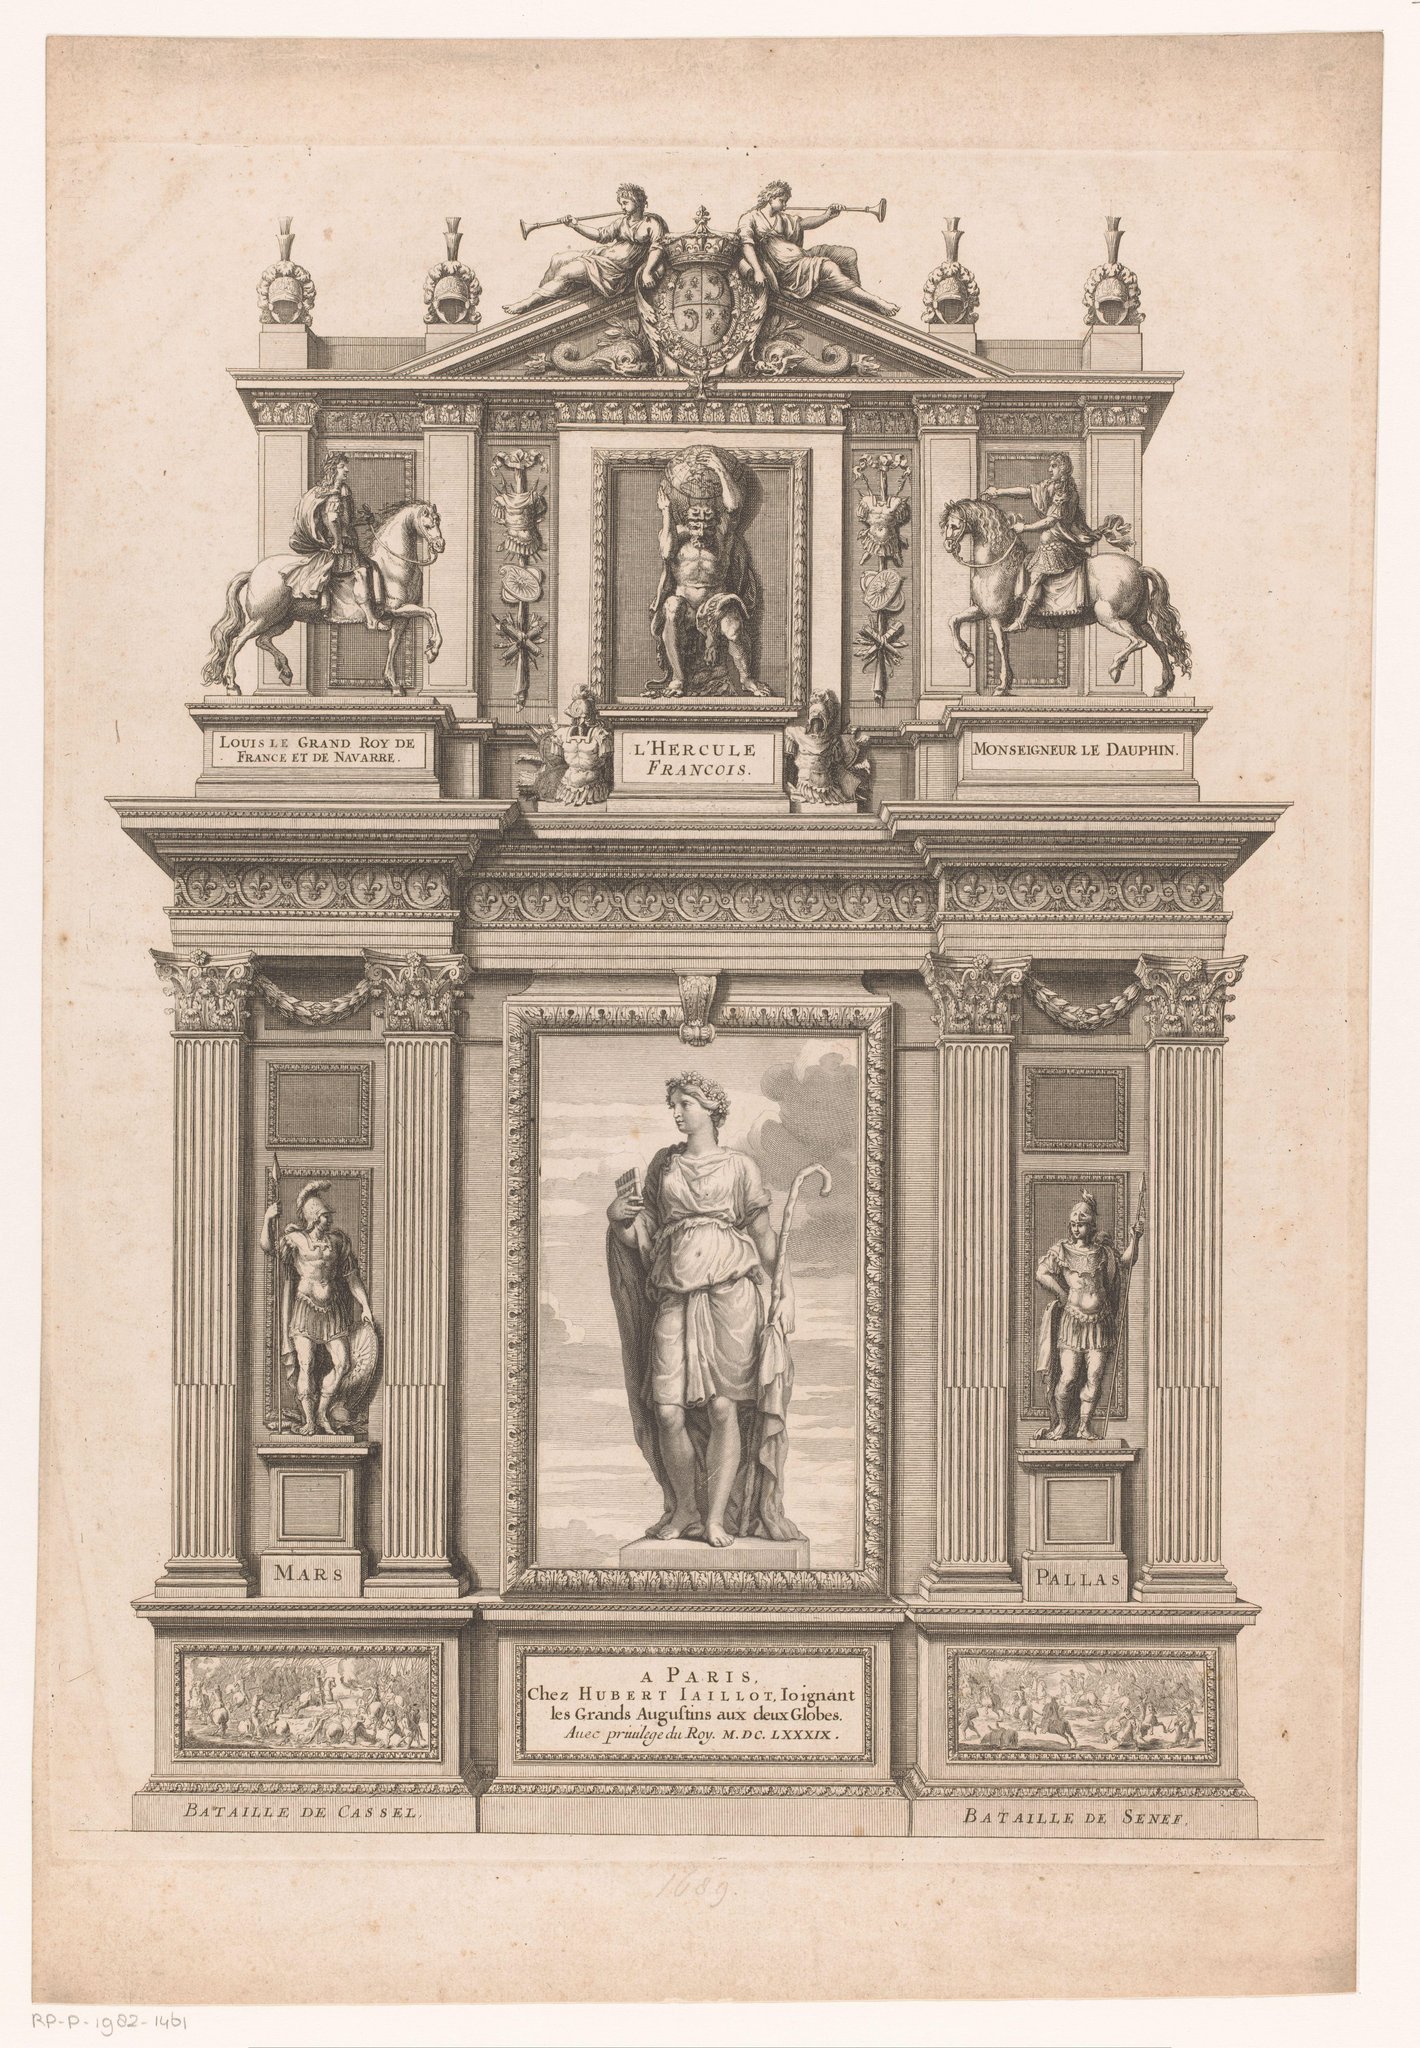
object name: print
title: Façade met herderin, goden en ruiterstandbeelden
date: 1689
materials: paper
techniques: engraving, etching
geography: amsterdam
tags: herding, herdsman, herdswoman, shepherd, shepherdess, cowherd, etc., equestrian statue, façade (of house or building), roman deities, and foreign deities included in the classical pantheon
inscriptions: collector's mark: Lugt 2760, collector's mark: Lugt 2228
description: Façade met in het midden een staande herderin met panfluit en staf. Links en rechts van haar staan de goden Mars en Pallas Athena op voetstukken tussen pilasters. Daarboven draagt Hercules de wereld op zijn schouders. Ruiterstandbeelden van Lodewijk XIV van Frankrijk en Lodewijk van Frankrijk flankeren hem. Aan de bovenzijde zitten twee op bazuinen blazende vrouwen aan weerszijden van een bekroond wapenschild. De prent is oorspronkelijk de titelpagina voor: Sanson, Nicolas, Atlas Nouveau Contenant Toutes les Parties du Monde (...), 1689. De titel is weggesneden en vervangen door de prent van de herderin.